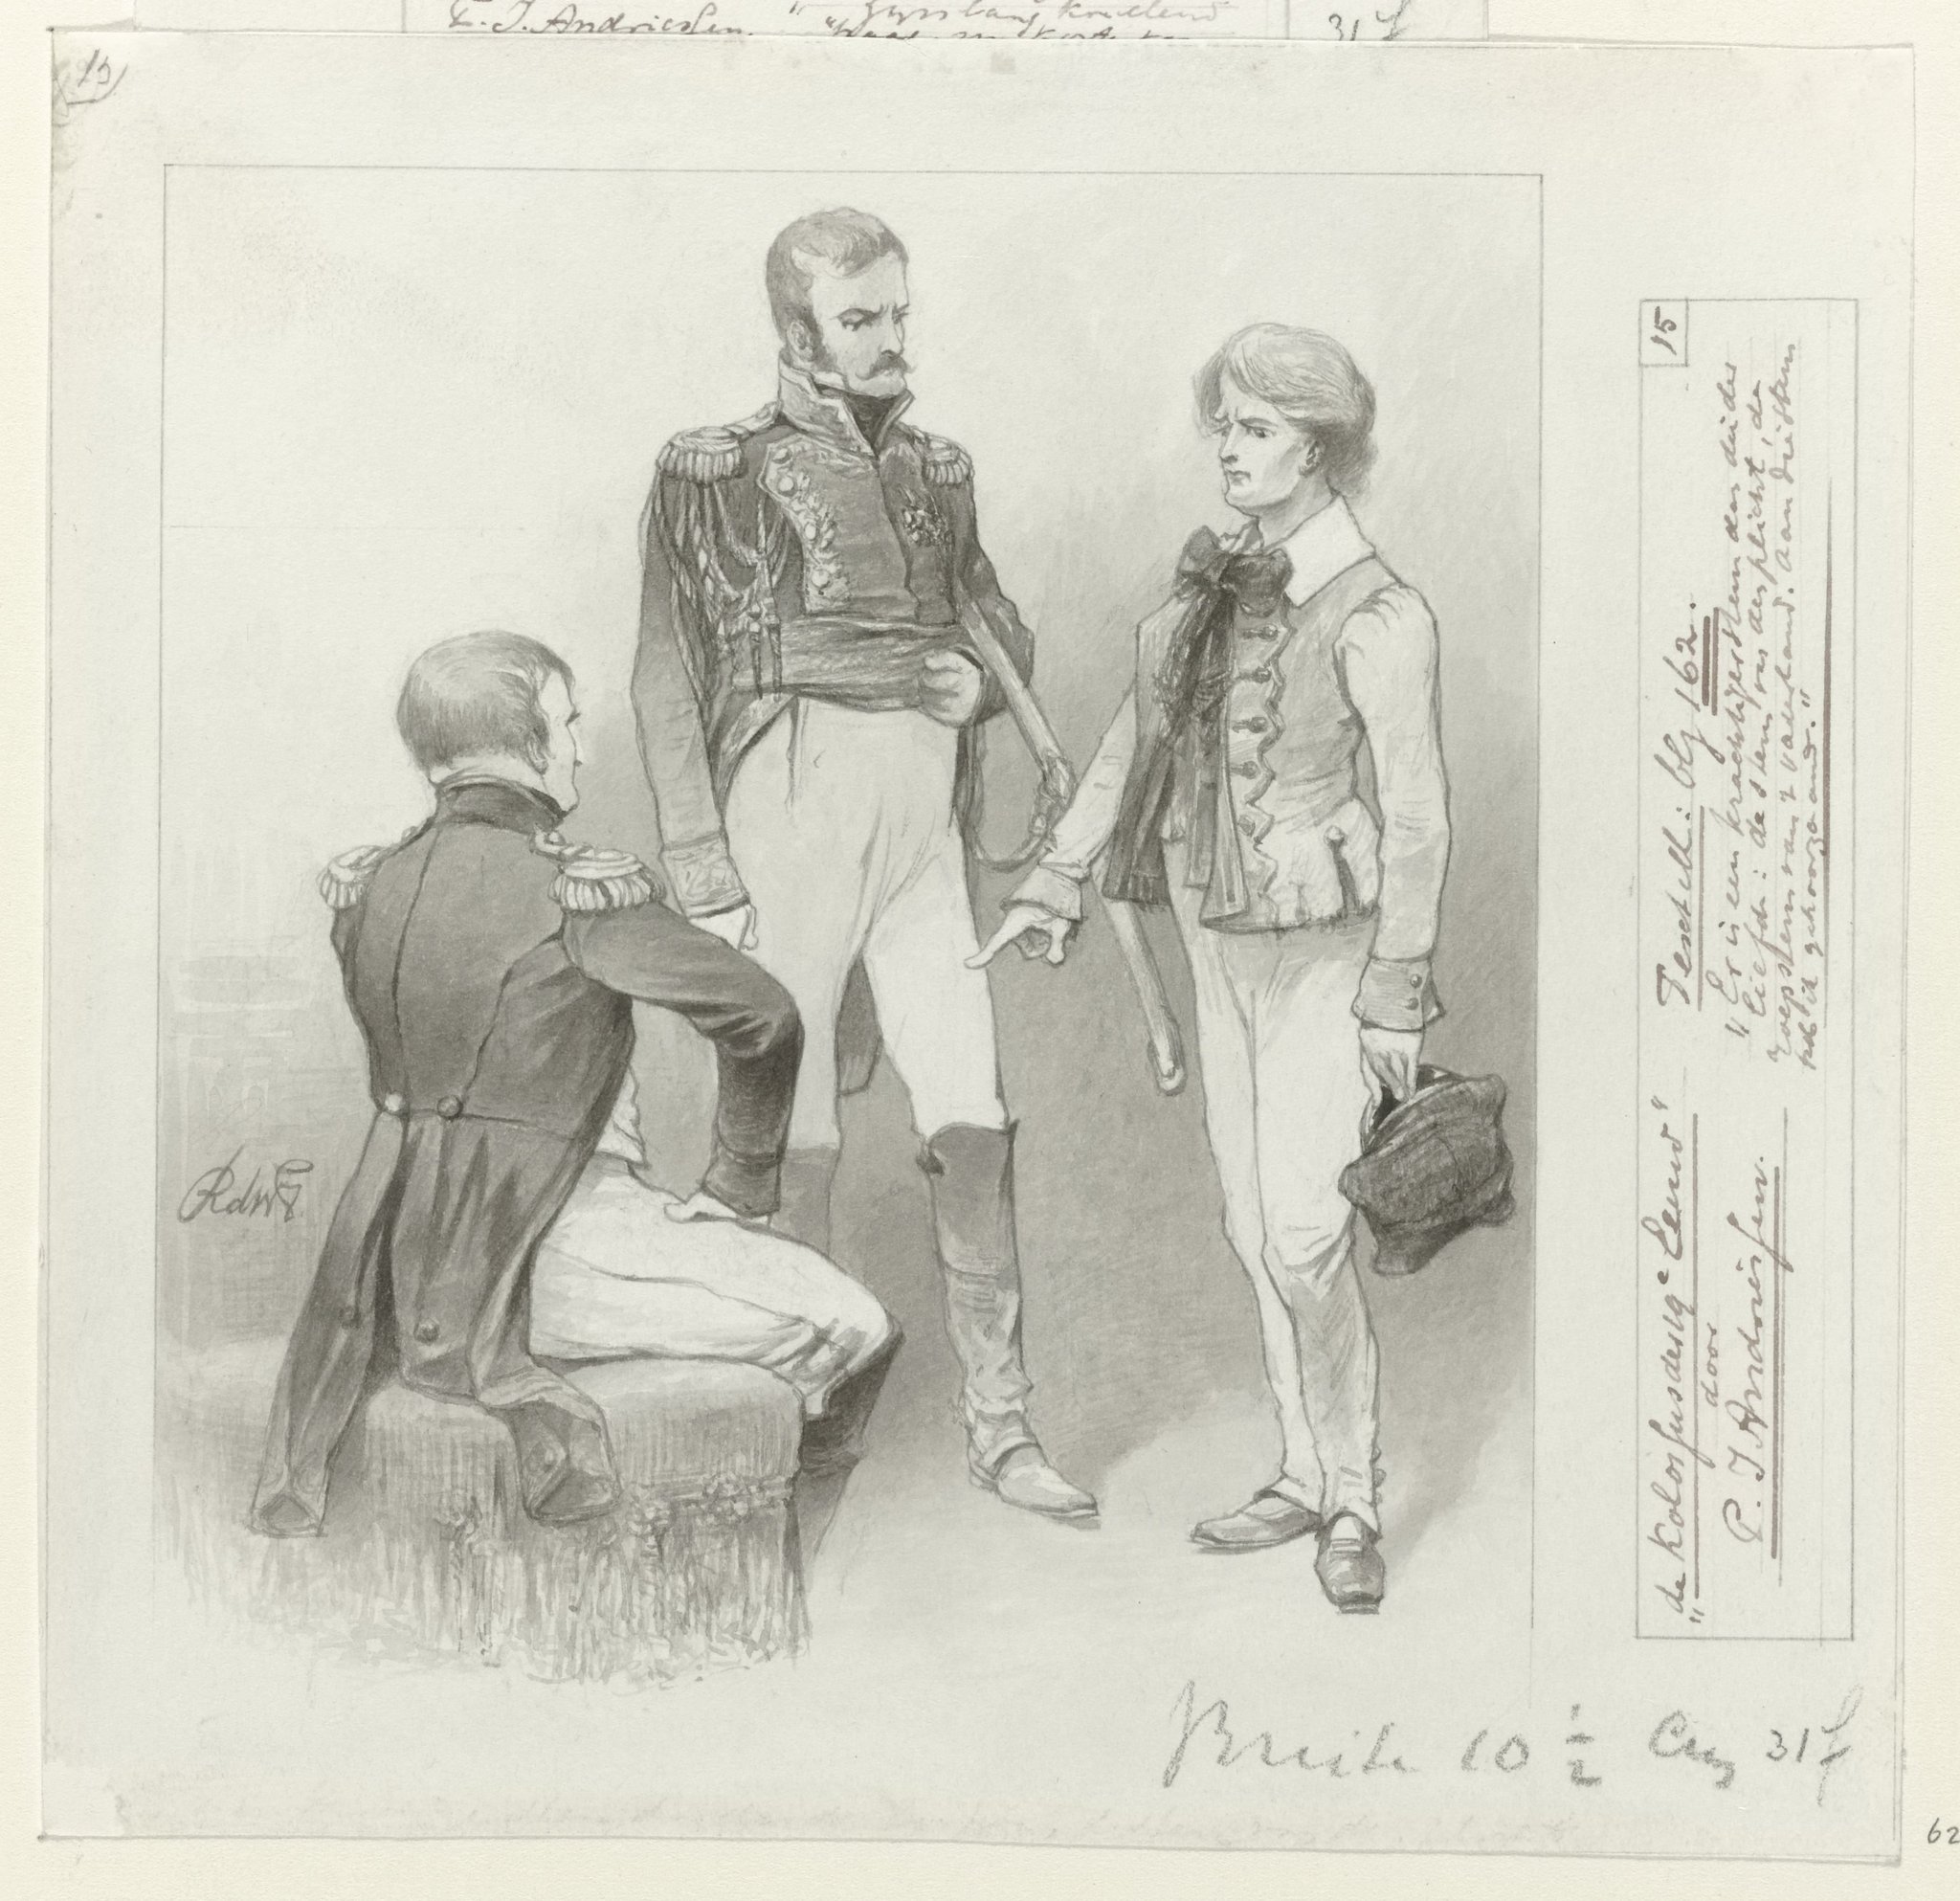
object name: drawing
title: Ontwerp voor illustratie voor De Kolossus der Negentiende Eeuw door P.J. Andriessen (Textill., blz. 162); scène uit het leven van Napoleon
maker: george lodewijk de wetstein pfister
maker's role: draughtsman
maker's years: 1867-1942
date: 1877-1942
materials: ink, paper, pencil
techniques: brush, pen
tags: napoleon i (emperor of the french), (andriessen, de kolossus der negentiende eeuw) specific works of literature (with author, title), historical persons, illustration ~ printed matter, book, historical events and situations